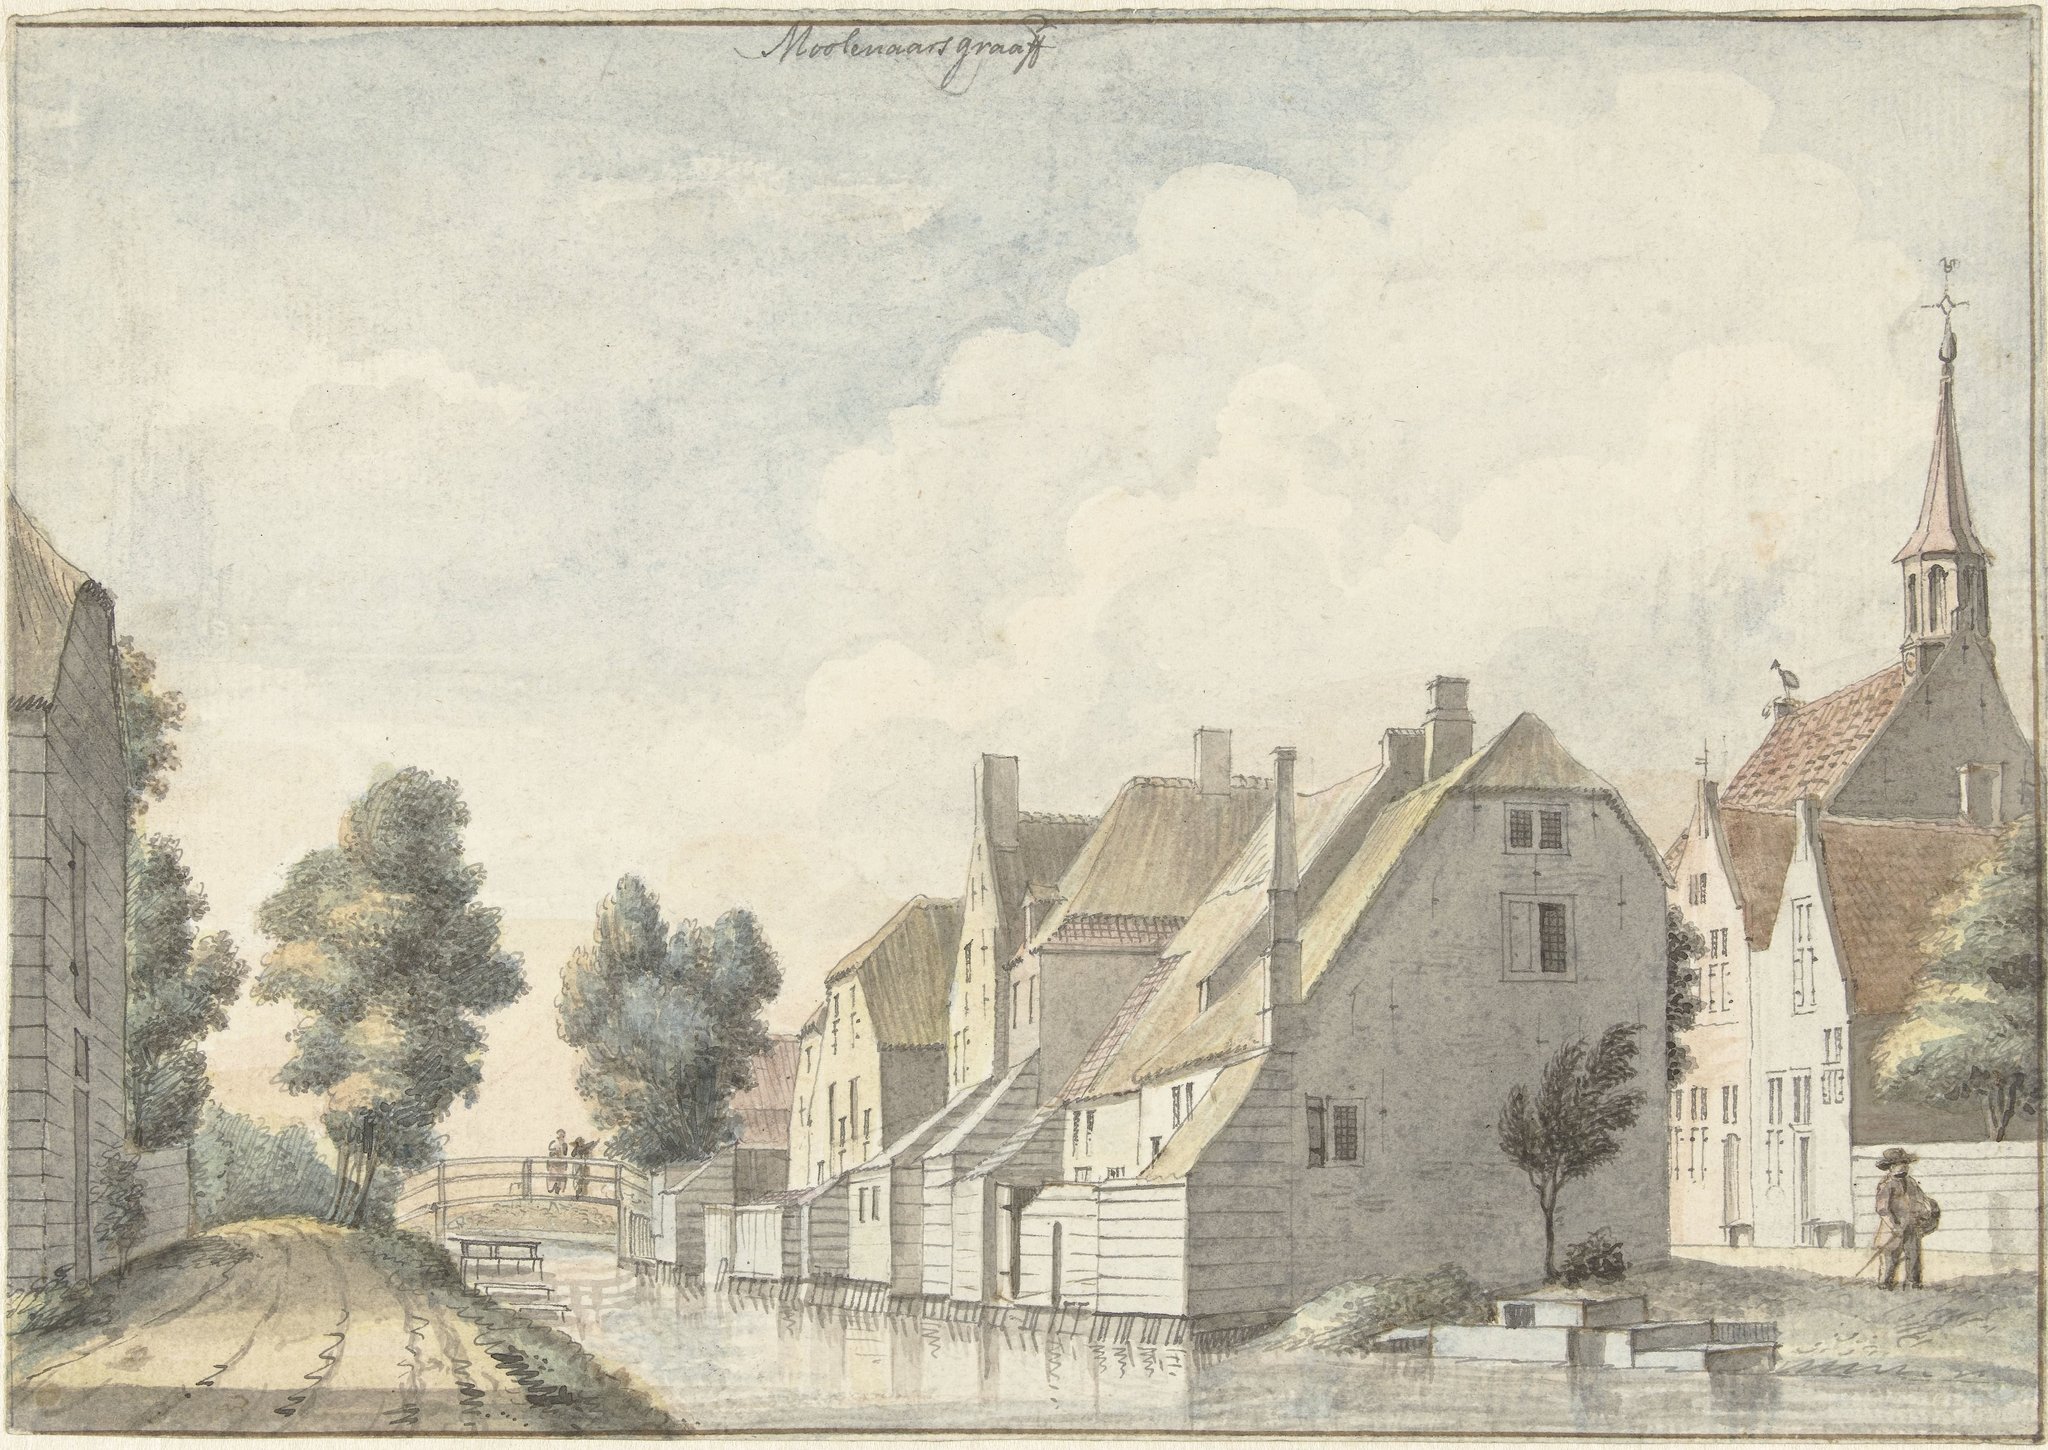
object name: watercolor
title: Het dorp Molenaarsgraaf in de Alblasserwaard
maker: joseph adolf schmetterling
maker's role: draughtsman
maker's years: 1751-1828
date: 1761-1828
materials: ink, paper, watercolor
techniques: brush, pen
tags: founding a village